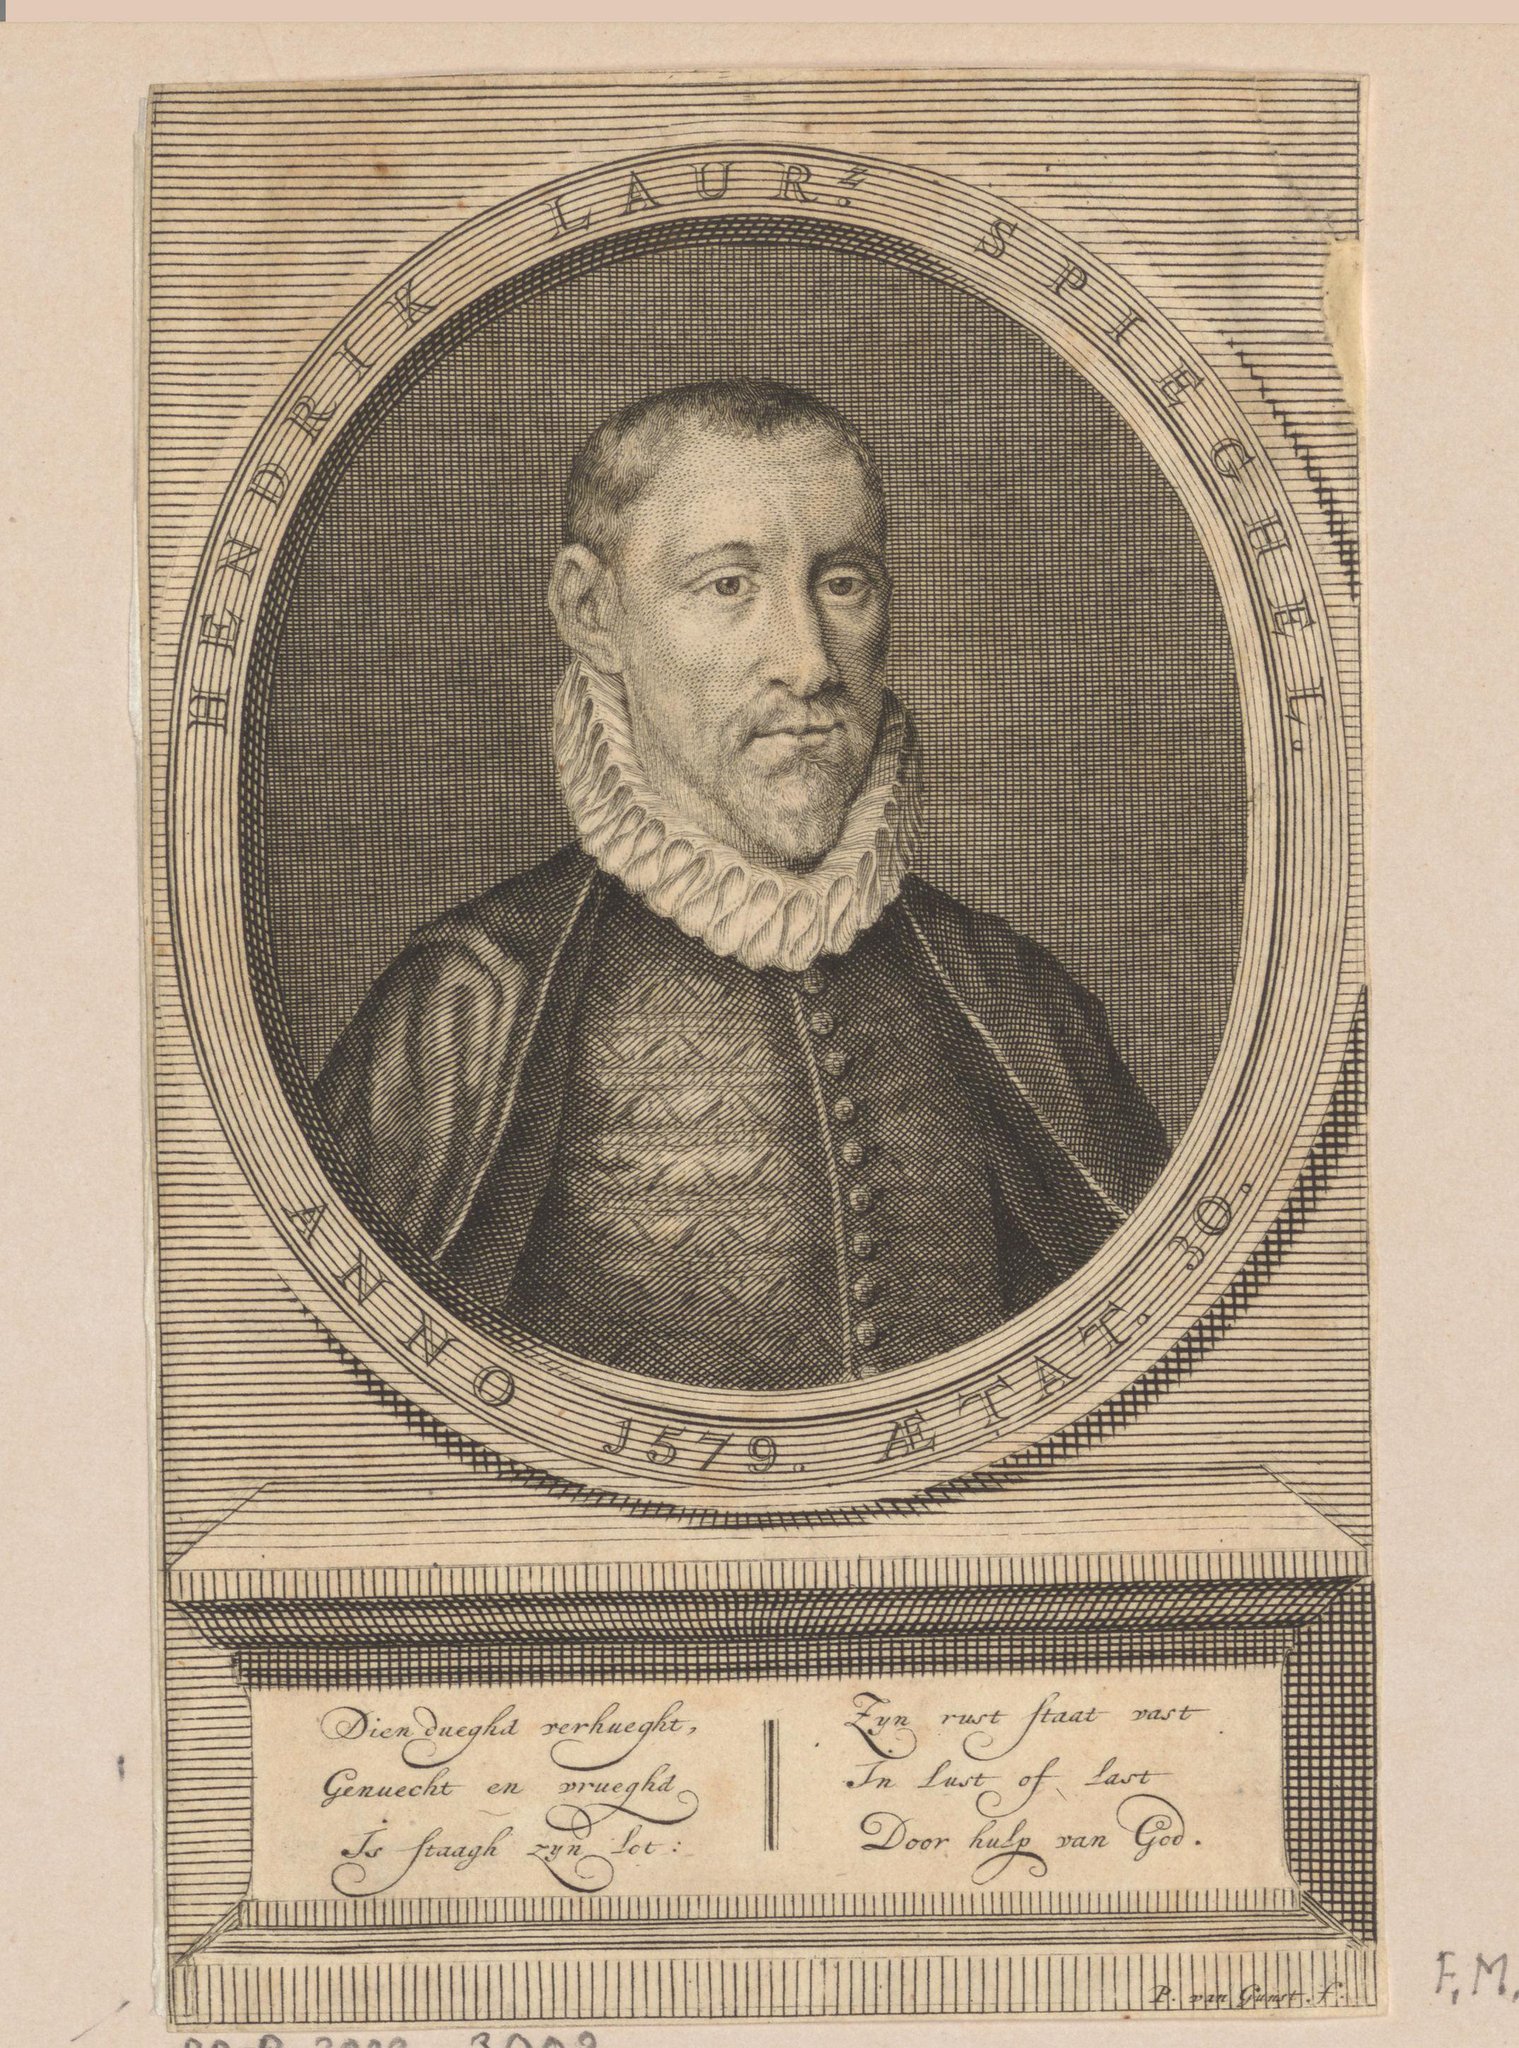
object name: print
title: Portret van Hendrick Laurensz. Spieghel op 30-jarige leeftijd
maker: pieter van gunst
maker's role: print maker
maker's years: 1658-1731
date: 1659-1731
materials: paper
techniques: engraving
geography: amsterdam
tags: amsterdam, hendrick laurensz. spieghel, historical persons, portrait of a writer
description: Met drieregelig onderschrift in twee kolommen in het Nederlands.